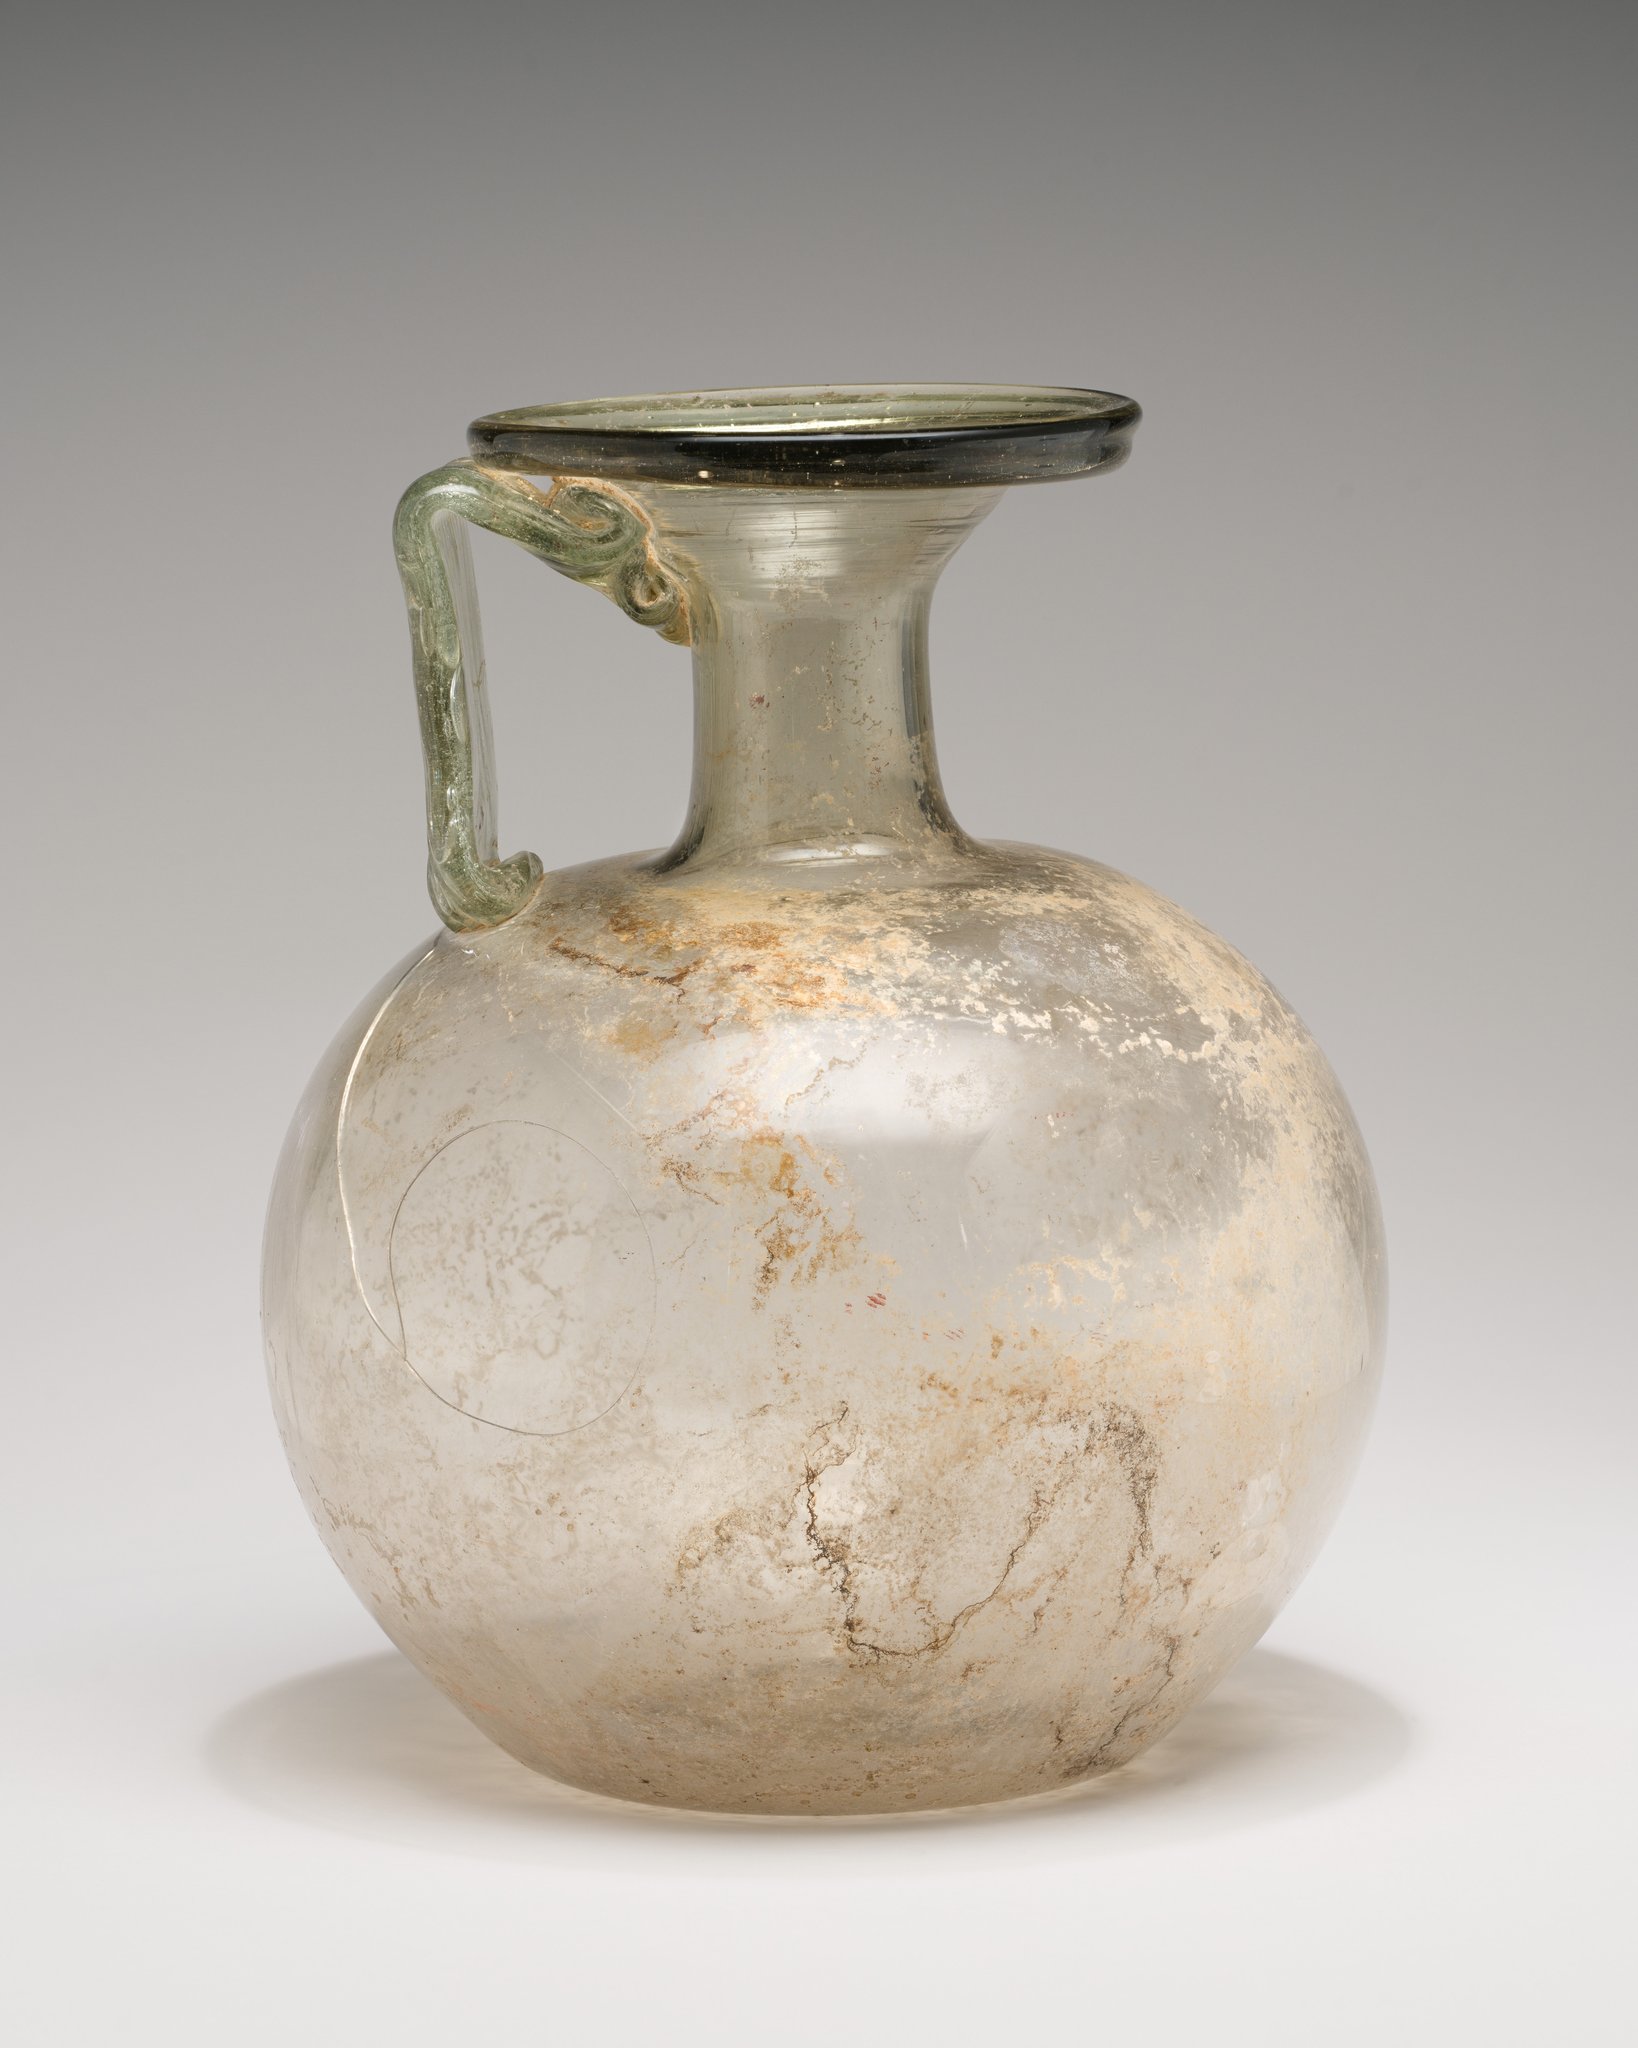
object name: jug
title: Glass jug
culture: roman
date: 201-400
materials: glass